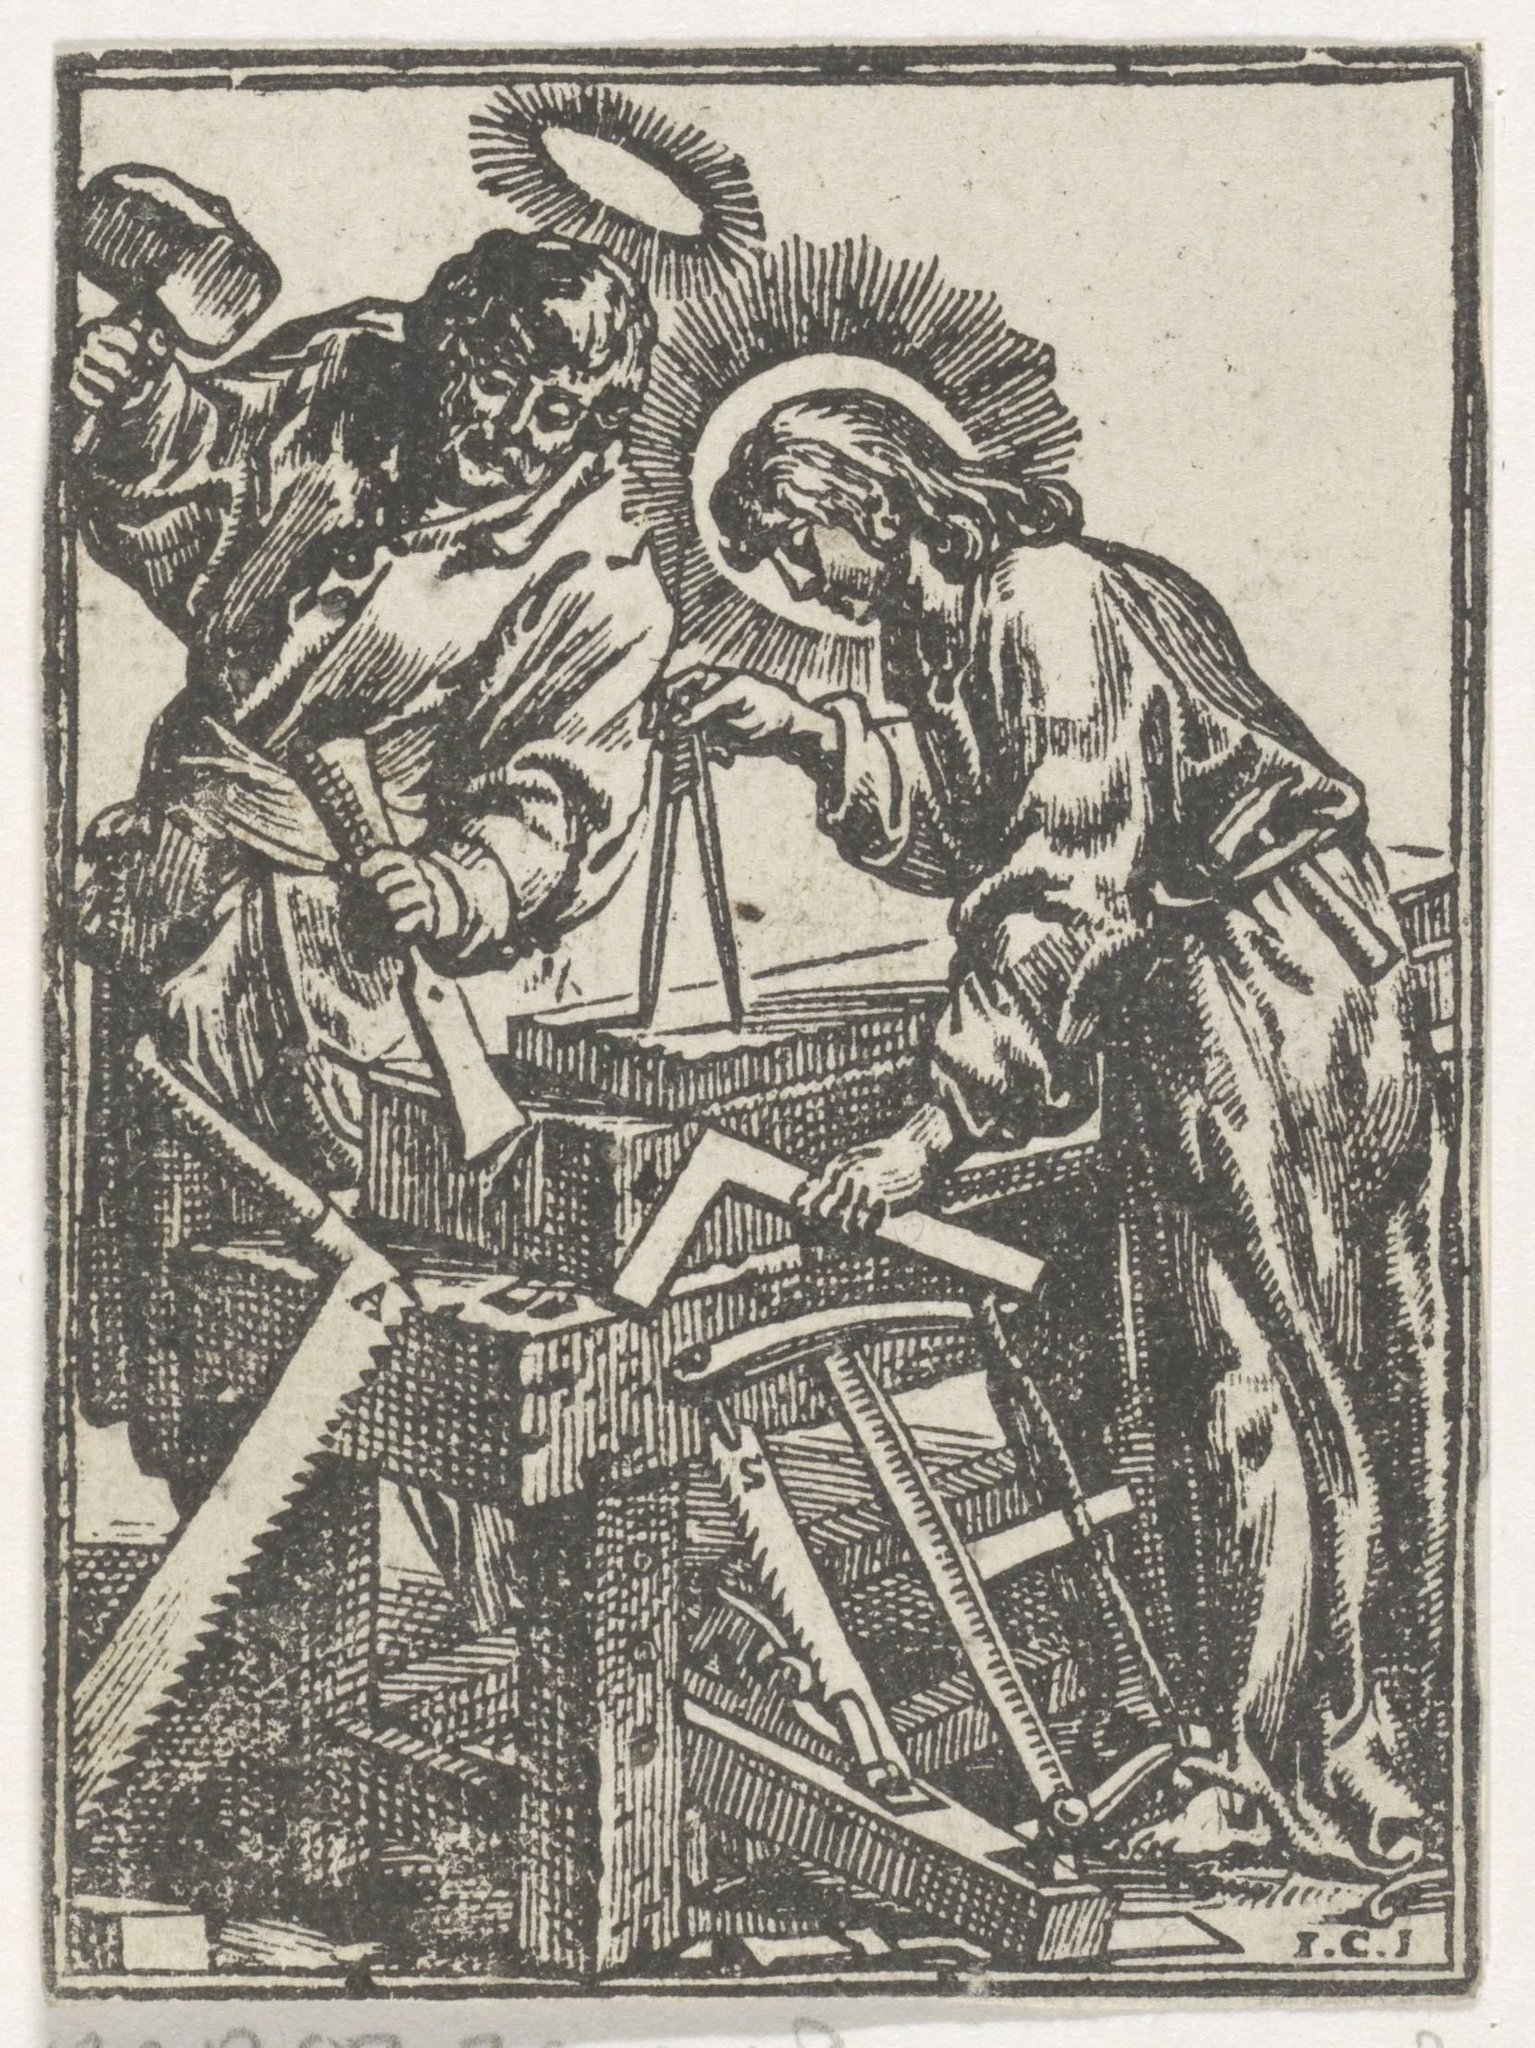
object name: book illustration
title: Christus helpt Jozef bij timmermanswerk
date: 1649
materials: paper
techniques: letterpress printing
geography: antwerp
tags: joseph with the christ-child (and mary) in his carpenter's workshop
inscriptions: collector's mark: Lugt 2228, collector's mark: Lugt 240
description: Prent uit: Andries, Judocus. Perpetua crux sive passio Jesu Christi. Antwerpen: Cornelis Woons, 1649.